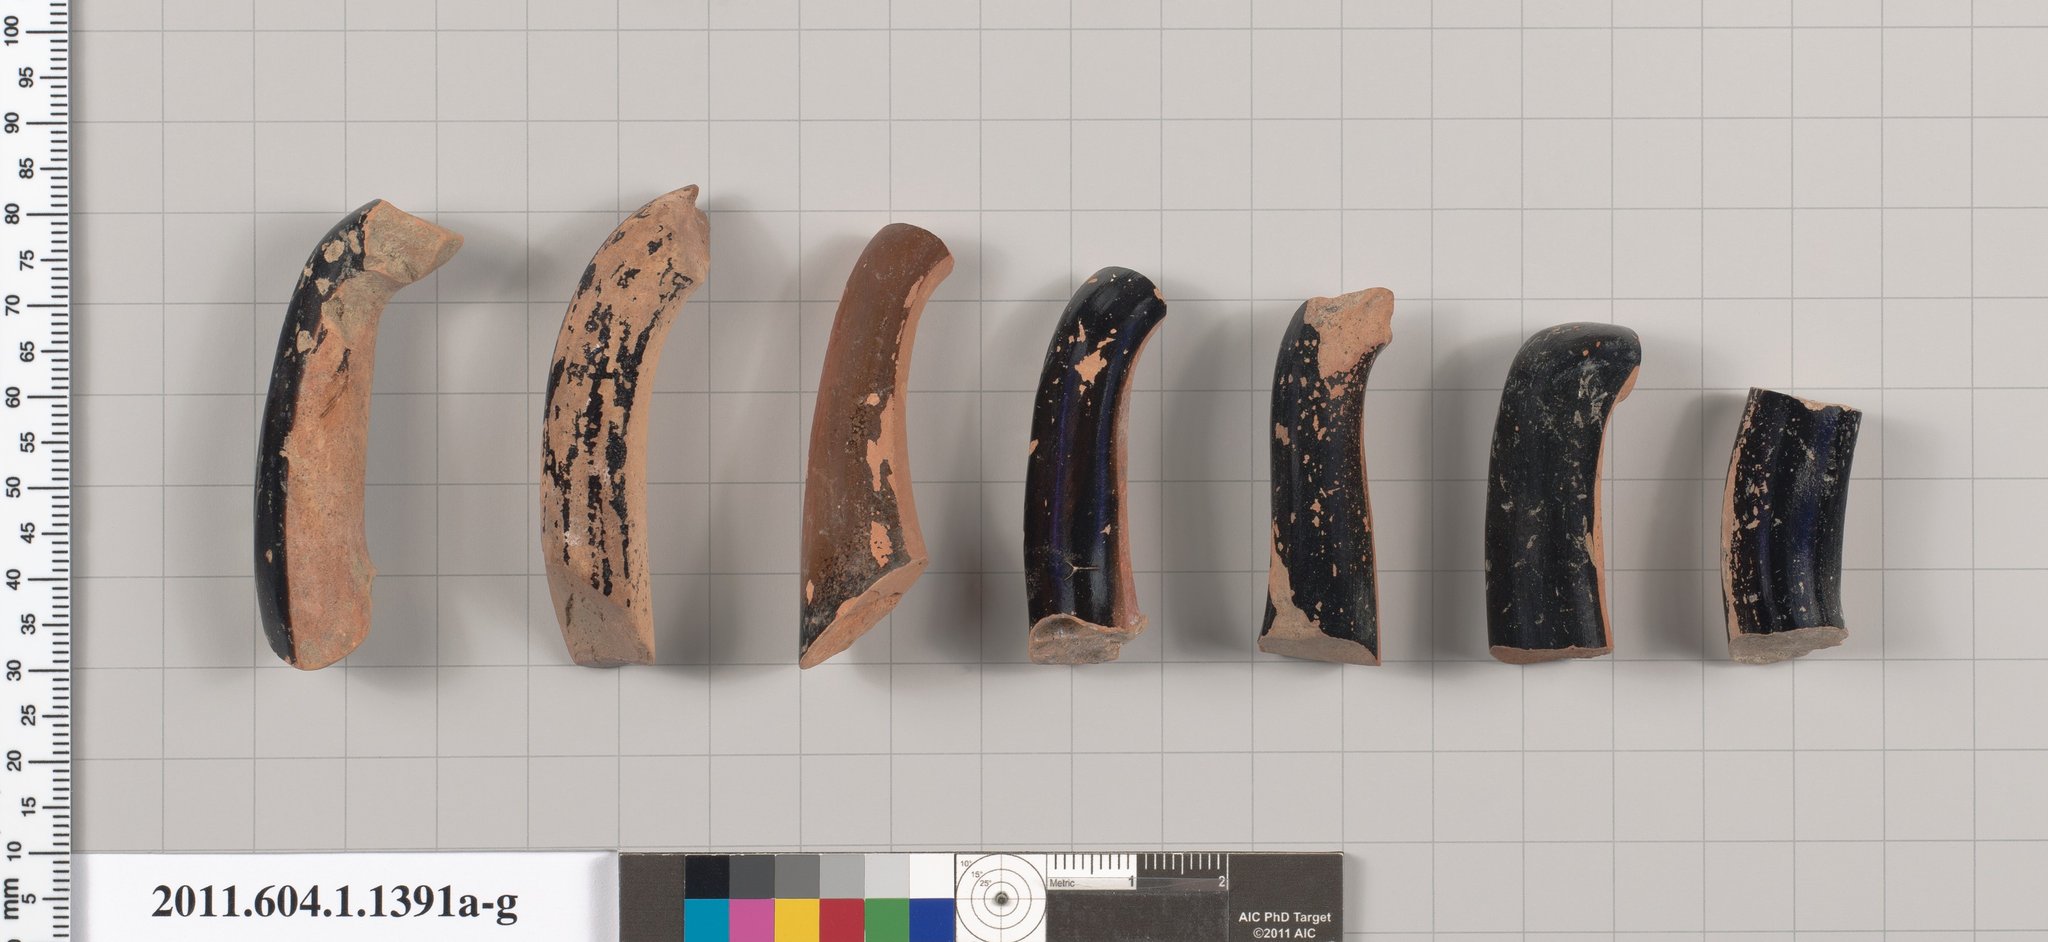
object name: kylix fragment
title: Terracotta fragments of kylikes (drinking cups)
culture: greek, attic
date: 500-401 BCE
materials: terracotta